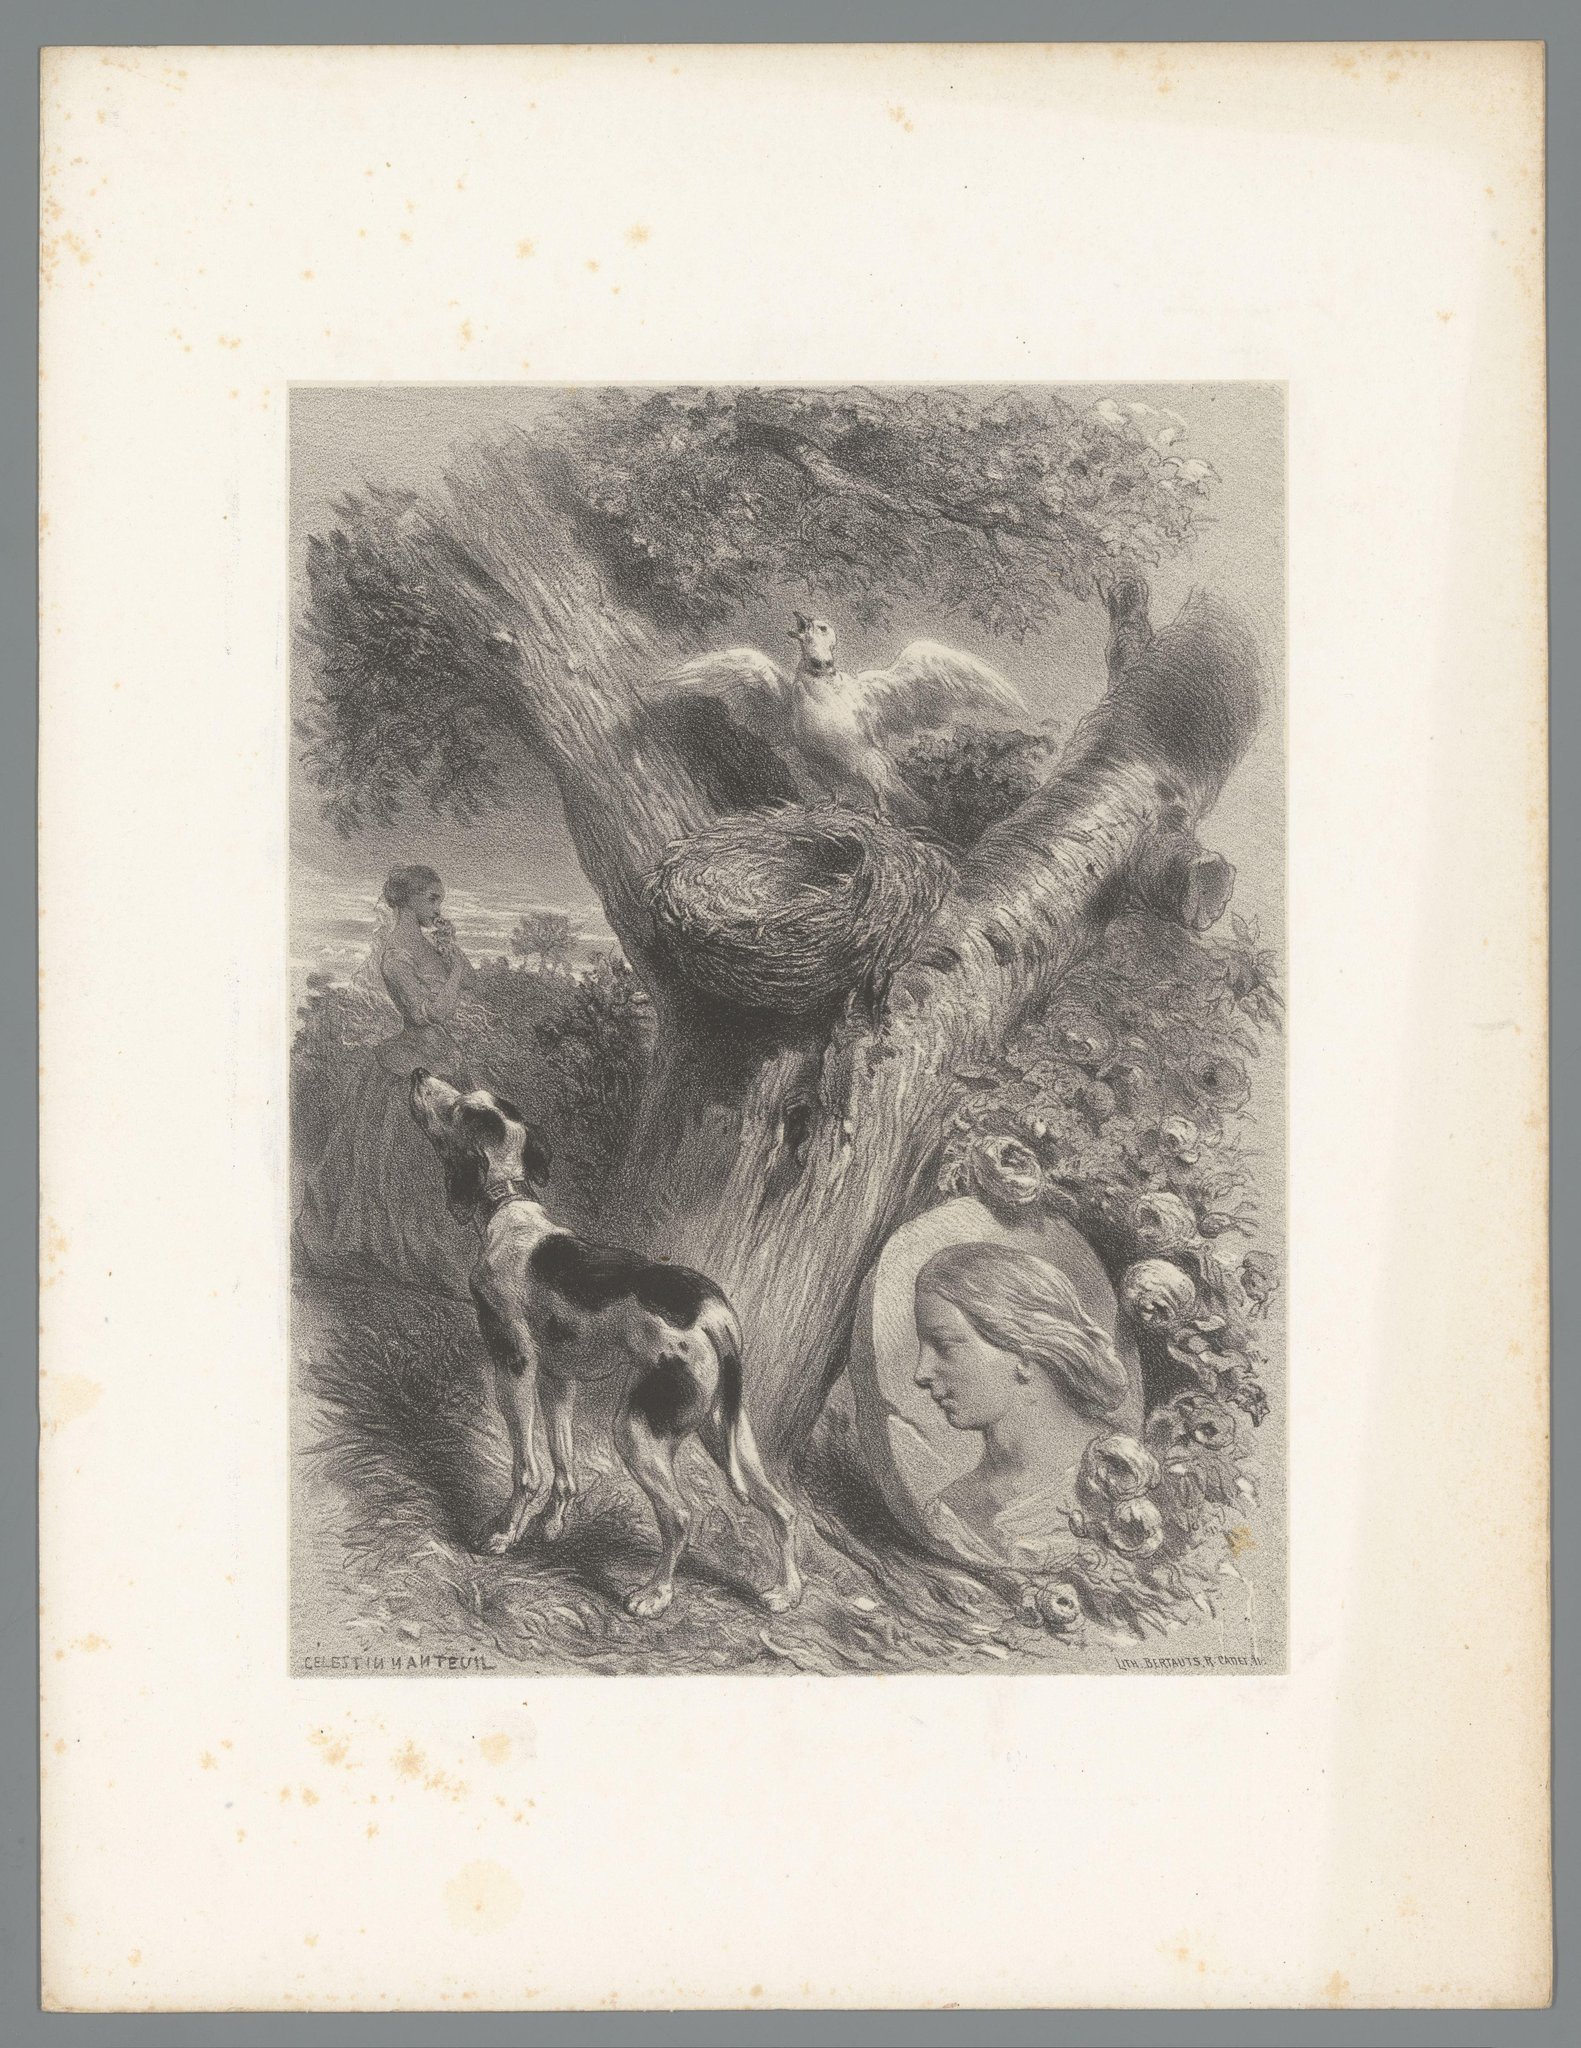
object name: print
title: Vogel bij zijn nest met een vrouw op de achtergrond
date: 1851-1865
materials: paper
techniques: lithograph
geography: paris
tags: other birds, ornament ~ medallion, female sex; woman, dog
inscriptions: collector's mark: Lugt 964